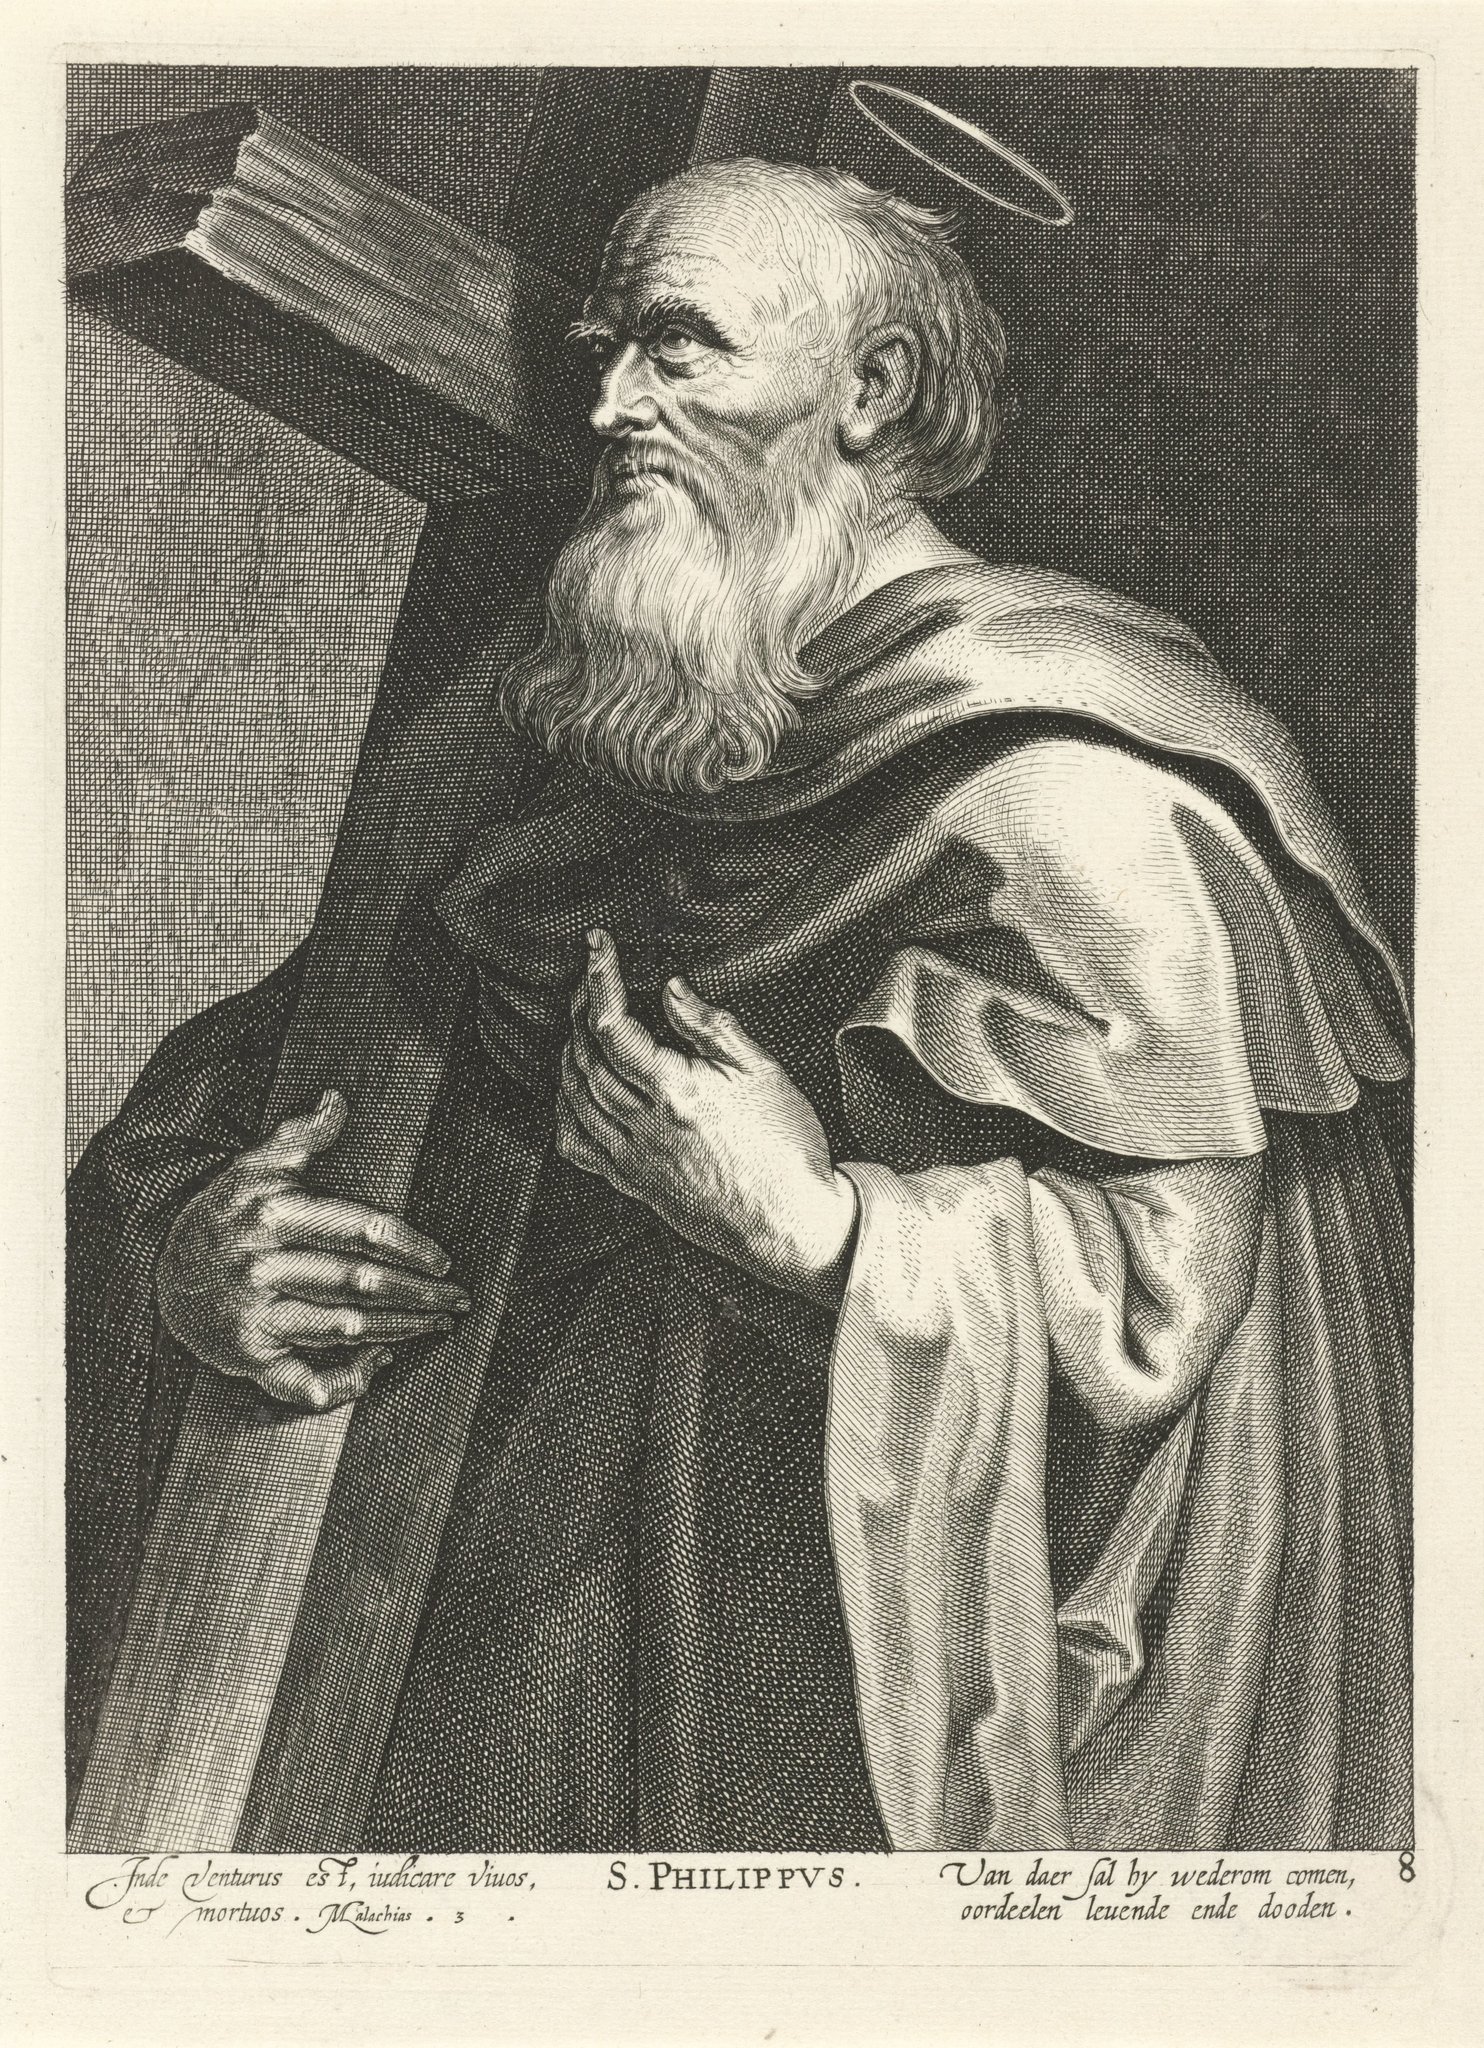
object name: print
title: Apostel Filippus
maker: nicolaes ryckmans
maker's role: print maker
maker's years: 1595-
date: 1616-1636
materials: paper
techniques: engraving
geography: southern netherlands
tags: the apostle philip; possible attributes: book, cross, dish with snake, lance, scroll, stone, sword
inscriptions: collector's mark: Lugt 240